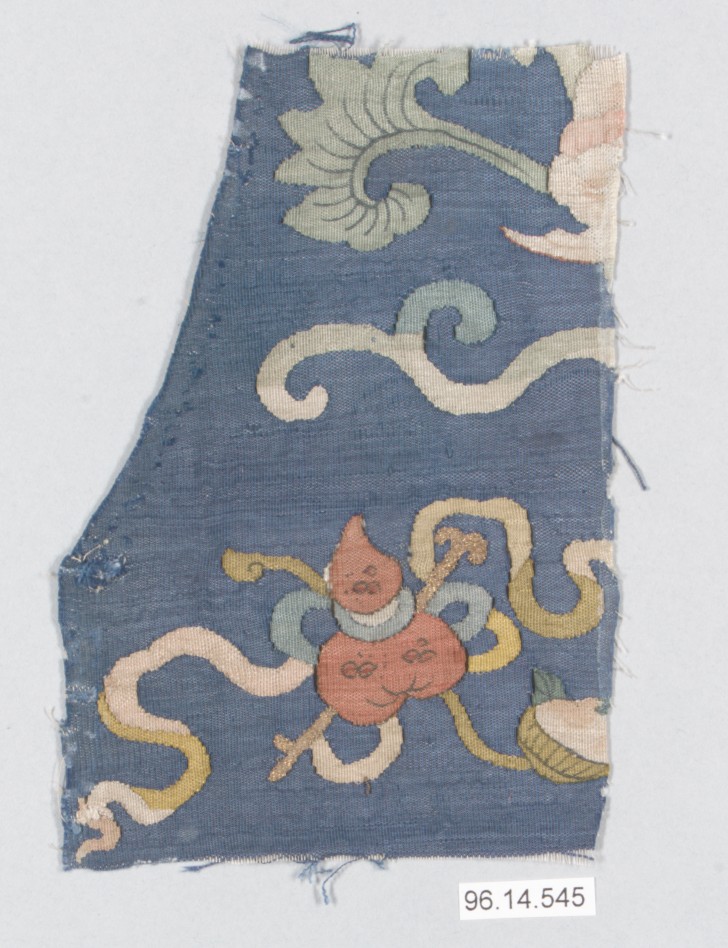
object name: piece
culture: chinese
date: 1701-1900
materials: silk